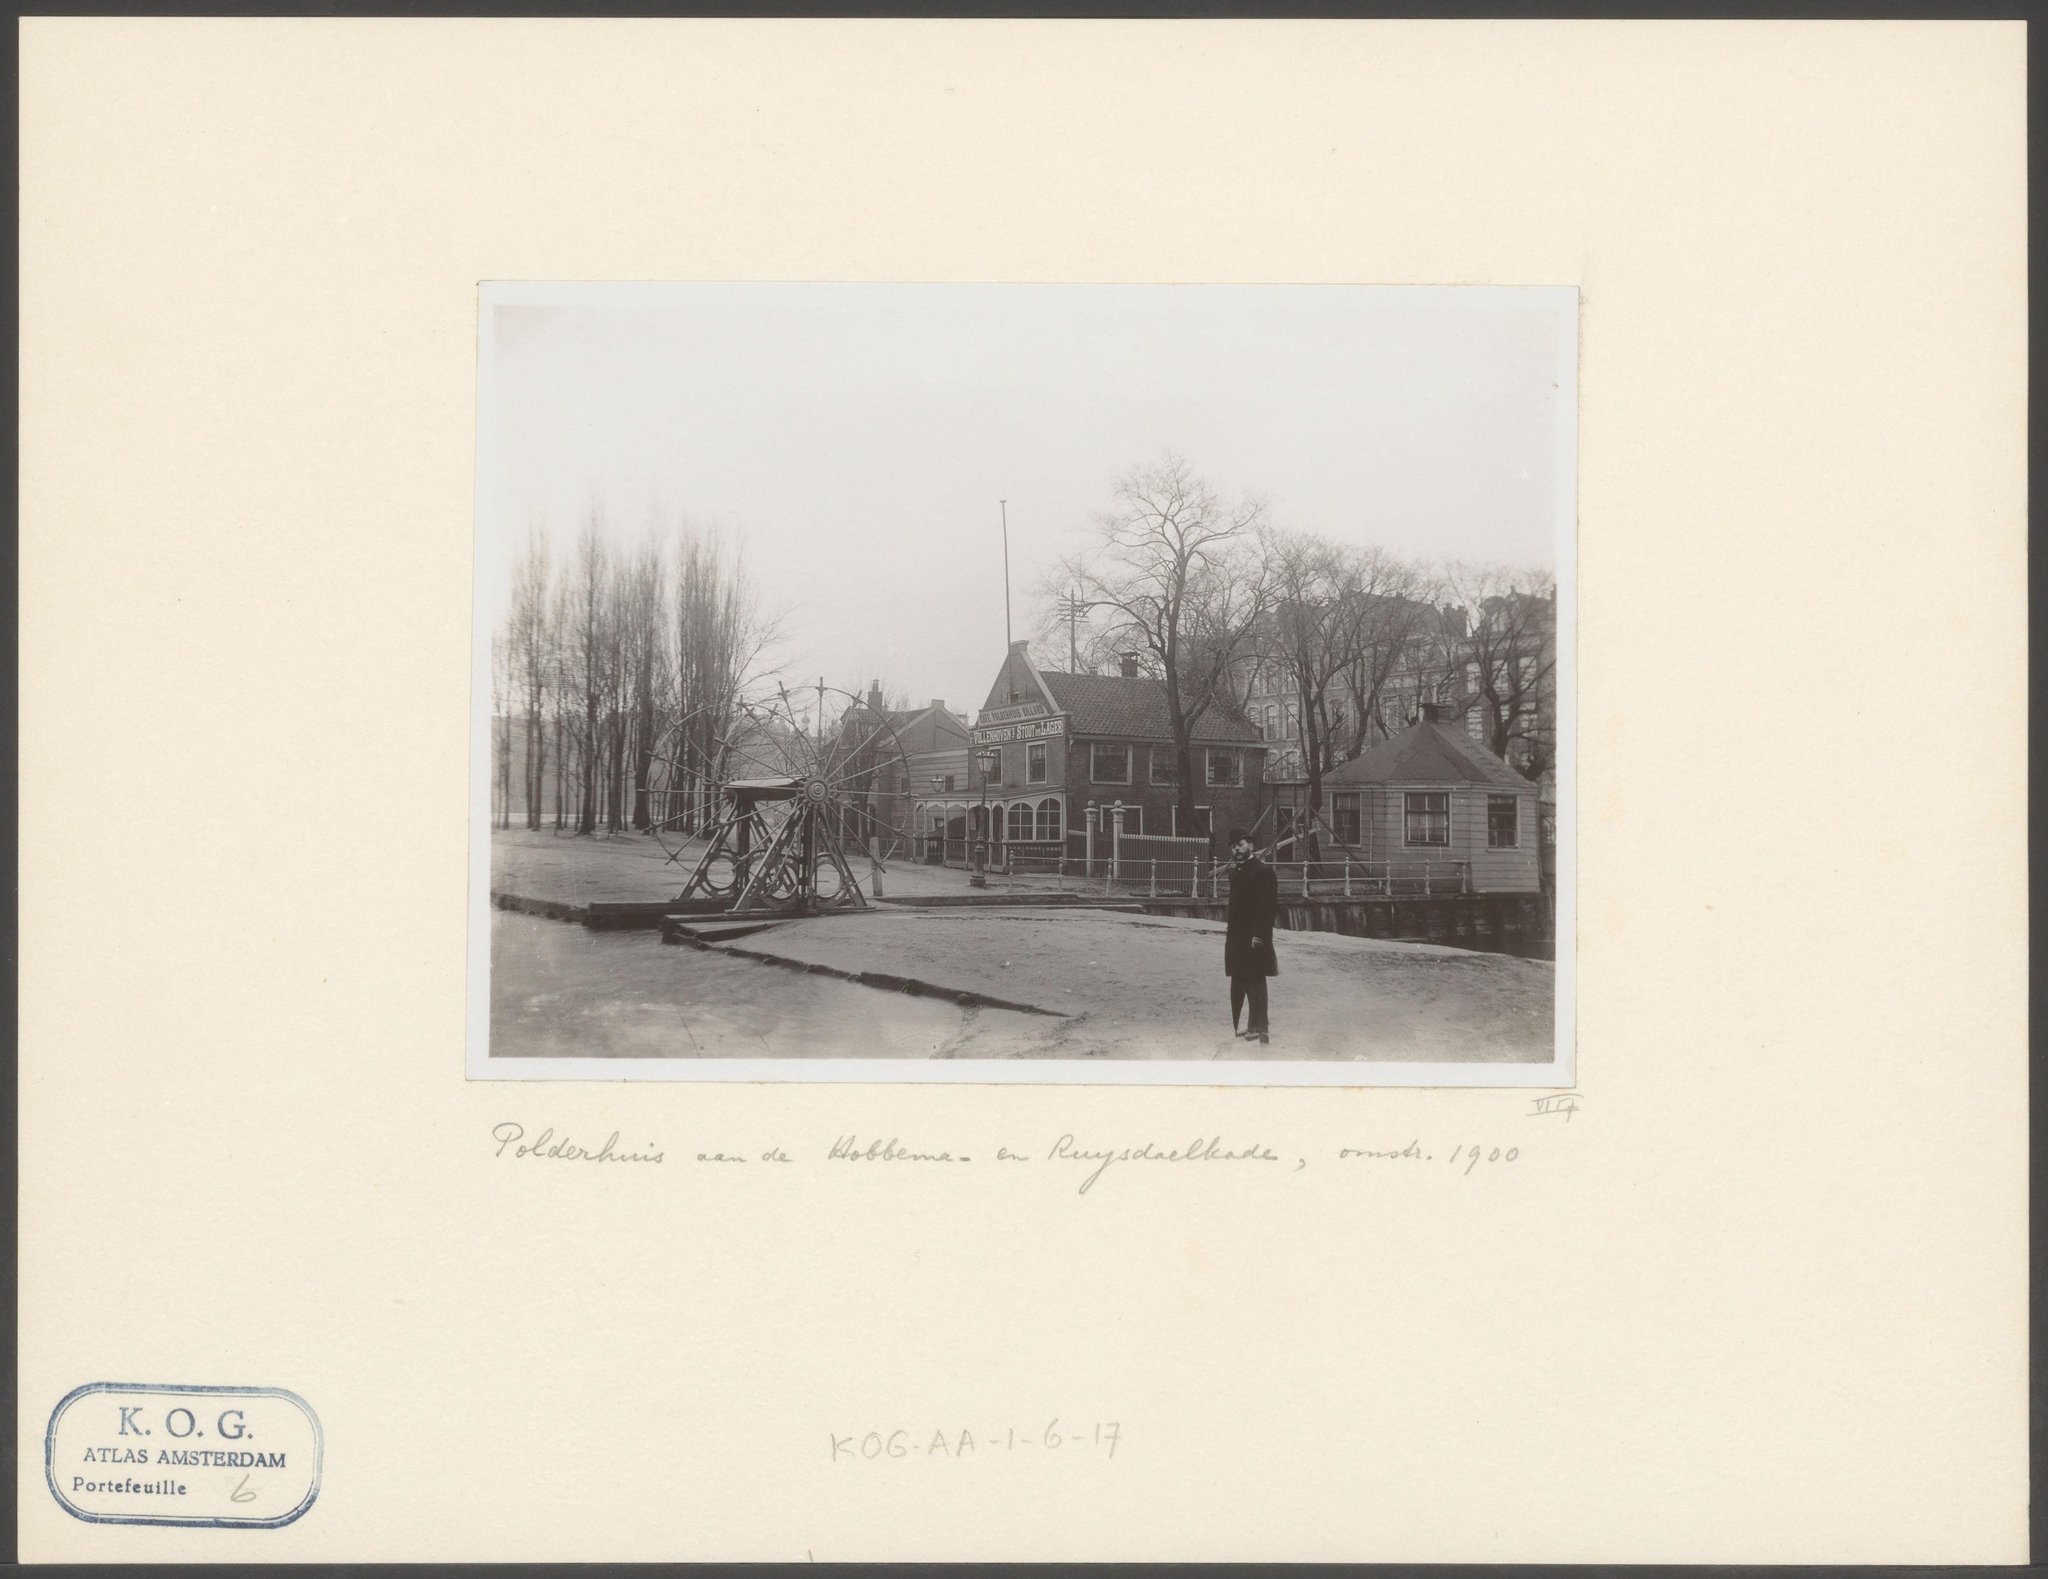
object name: photograph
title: Gezicht op het Polderhuis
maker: Anonymous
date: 1900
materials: paper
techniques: gelatin silver print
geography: amsterdam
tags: city-view in general; 'veduta', canal, inn, coffee-house, public house, etc., rolling bridge (dutch: 'overtoom')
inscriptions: inscription: ‘Polderhuis aan de Hobbema en Ruysdaelkade, omstr. 1900’, collector's mark: ‘6’ Lugt 1641b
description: Onderwerpsrubriek binnen de Atlas Amsterdam: Buitensingel of wel: Gezichten langs en op de Stadsvest van Raampoort tot Zeeburgerdijk.